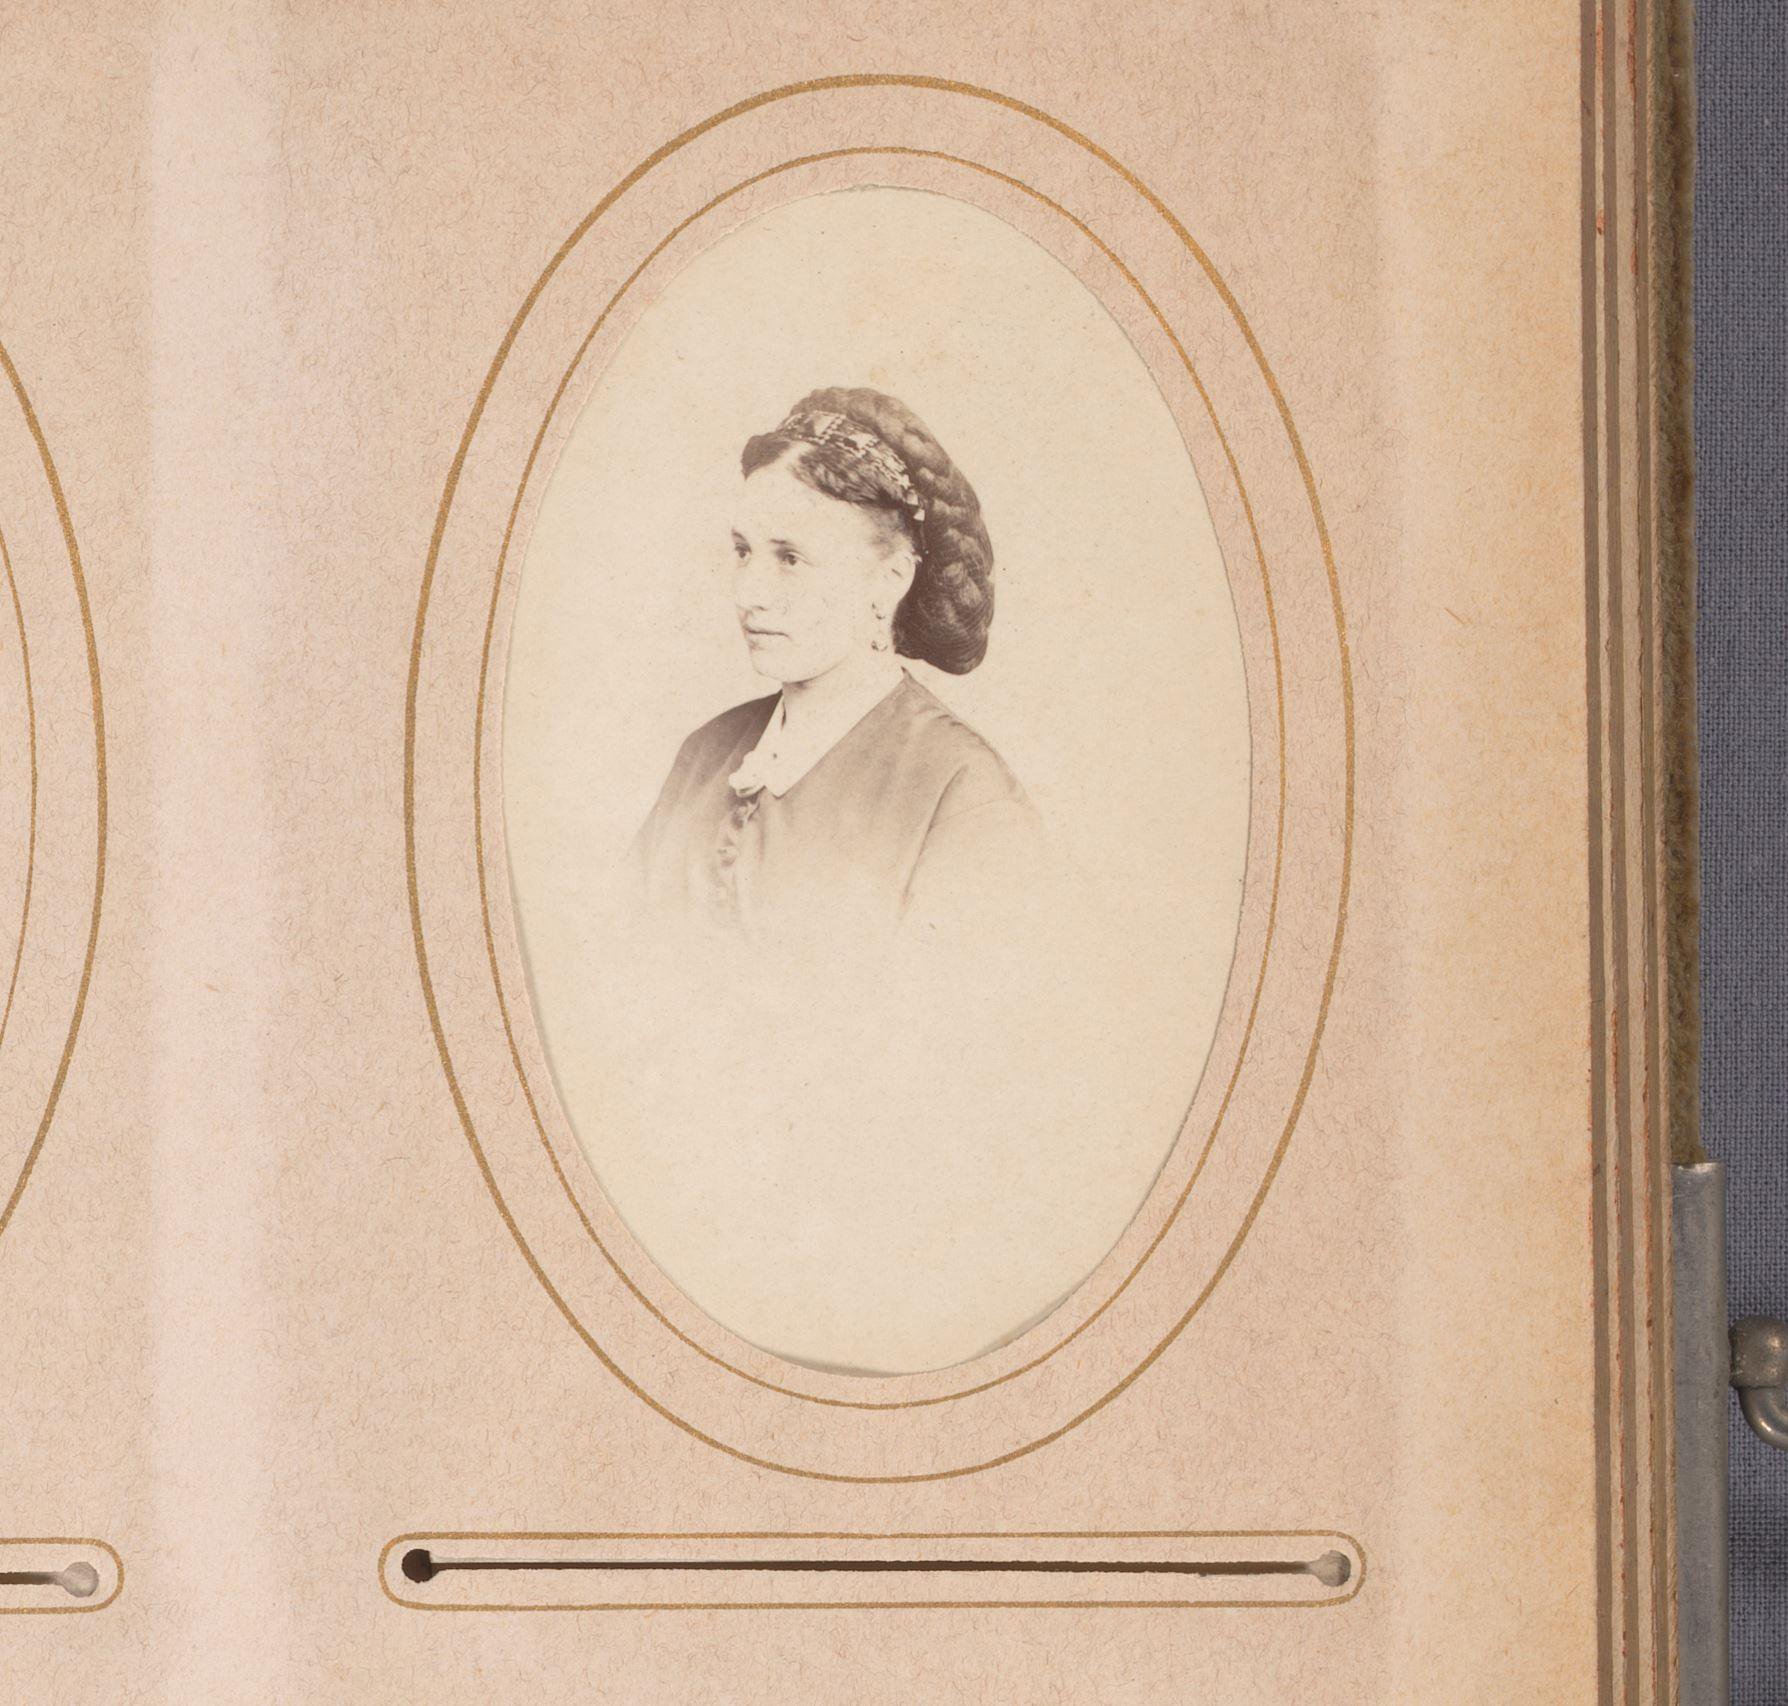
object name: carte de visite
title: Portret van een vrouw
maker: joseph coudroy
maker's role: fotograaf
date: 1860-1890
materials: cardboard, photographic support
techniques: albumen print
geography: roubaix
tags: historical persons - bb - woman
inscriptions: inscription: ‘Joseph Coudroy/ Photographe/ 13, Rue Neuve, 13/ Roubaix’